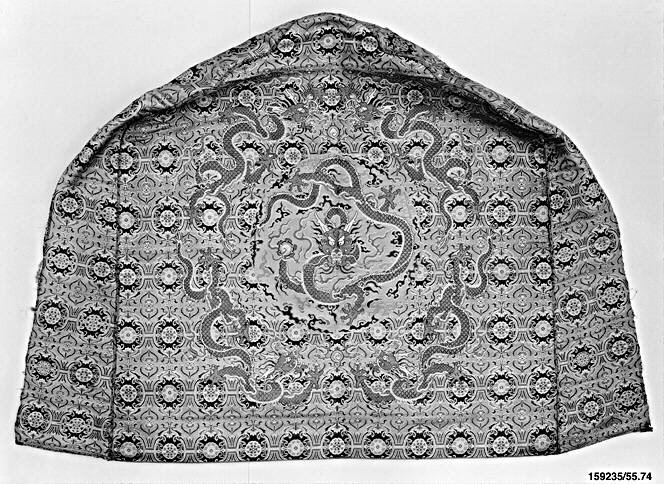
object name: cushion cover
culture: chinese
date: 1667-1700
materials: metal thread, silk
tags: dragons